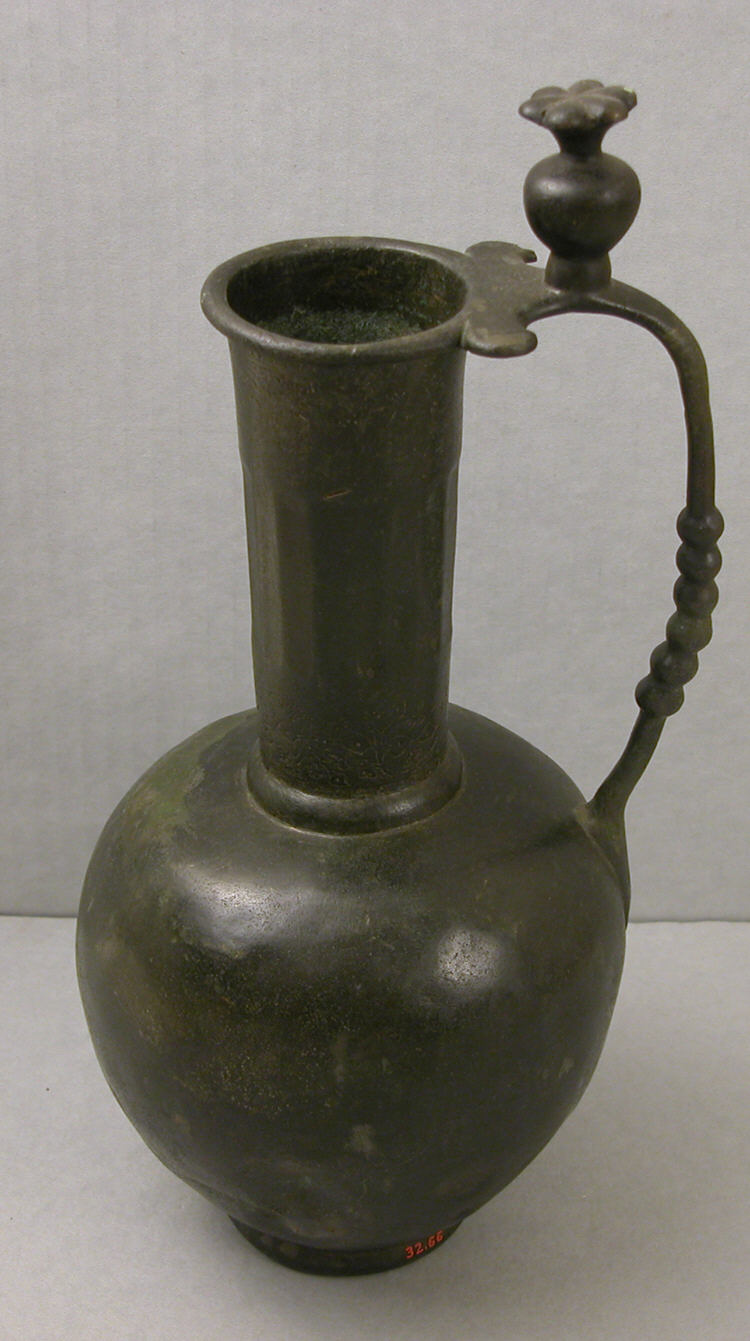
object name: ewer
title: Ewer with Pomegranate-shaped Thumb Rests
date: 1001-1200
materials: bronze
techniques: casting, chasing, engraving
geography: iran